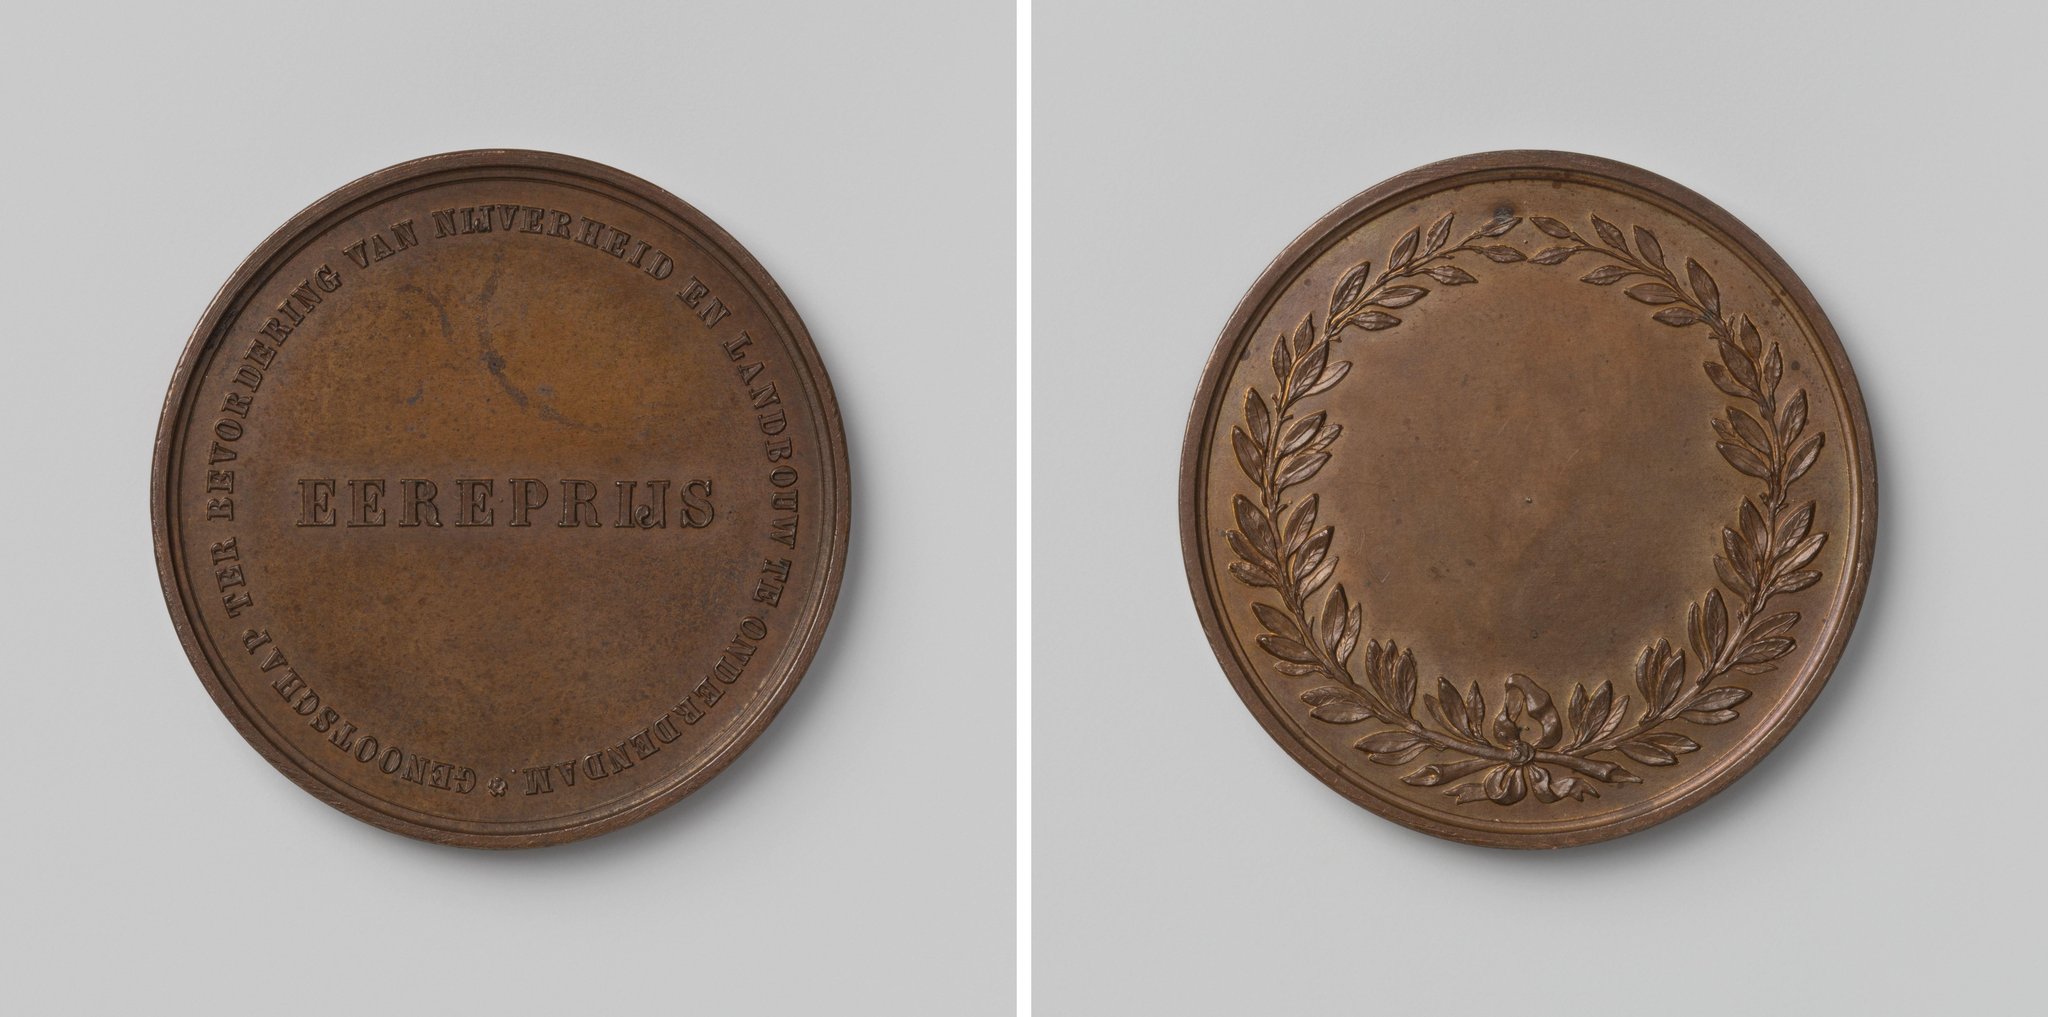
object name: medal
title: Genootschap ter Bevordering van Nijverheid en Landbouw te Onderdendam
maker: Anonymous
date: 1800-1850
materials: bronze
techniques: striking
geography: netherlands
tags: genootschap ter bevordering van nijverheid en landbouw, onderdendam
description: Bronzen penning. Voorzijde: opschrift binnen omschrift. Keerzijde: blanco veld binnen lauwerkrans